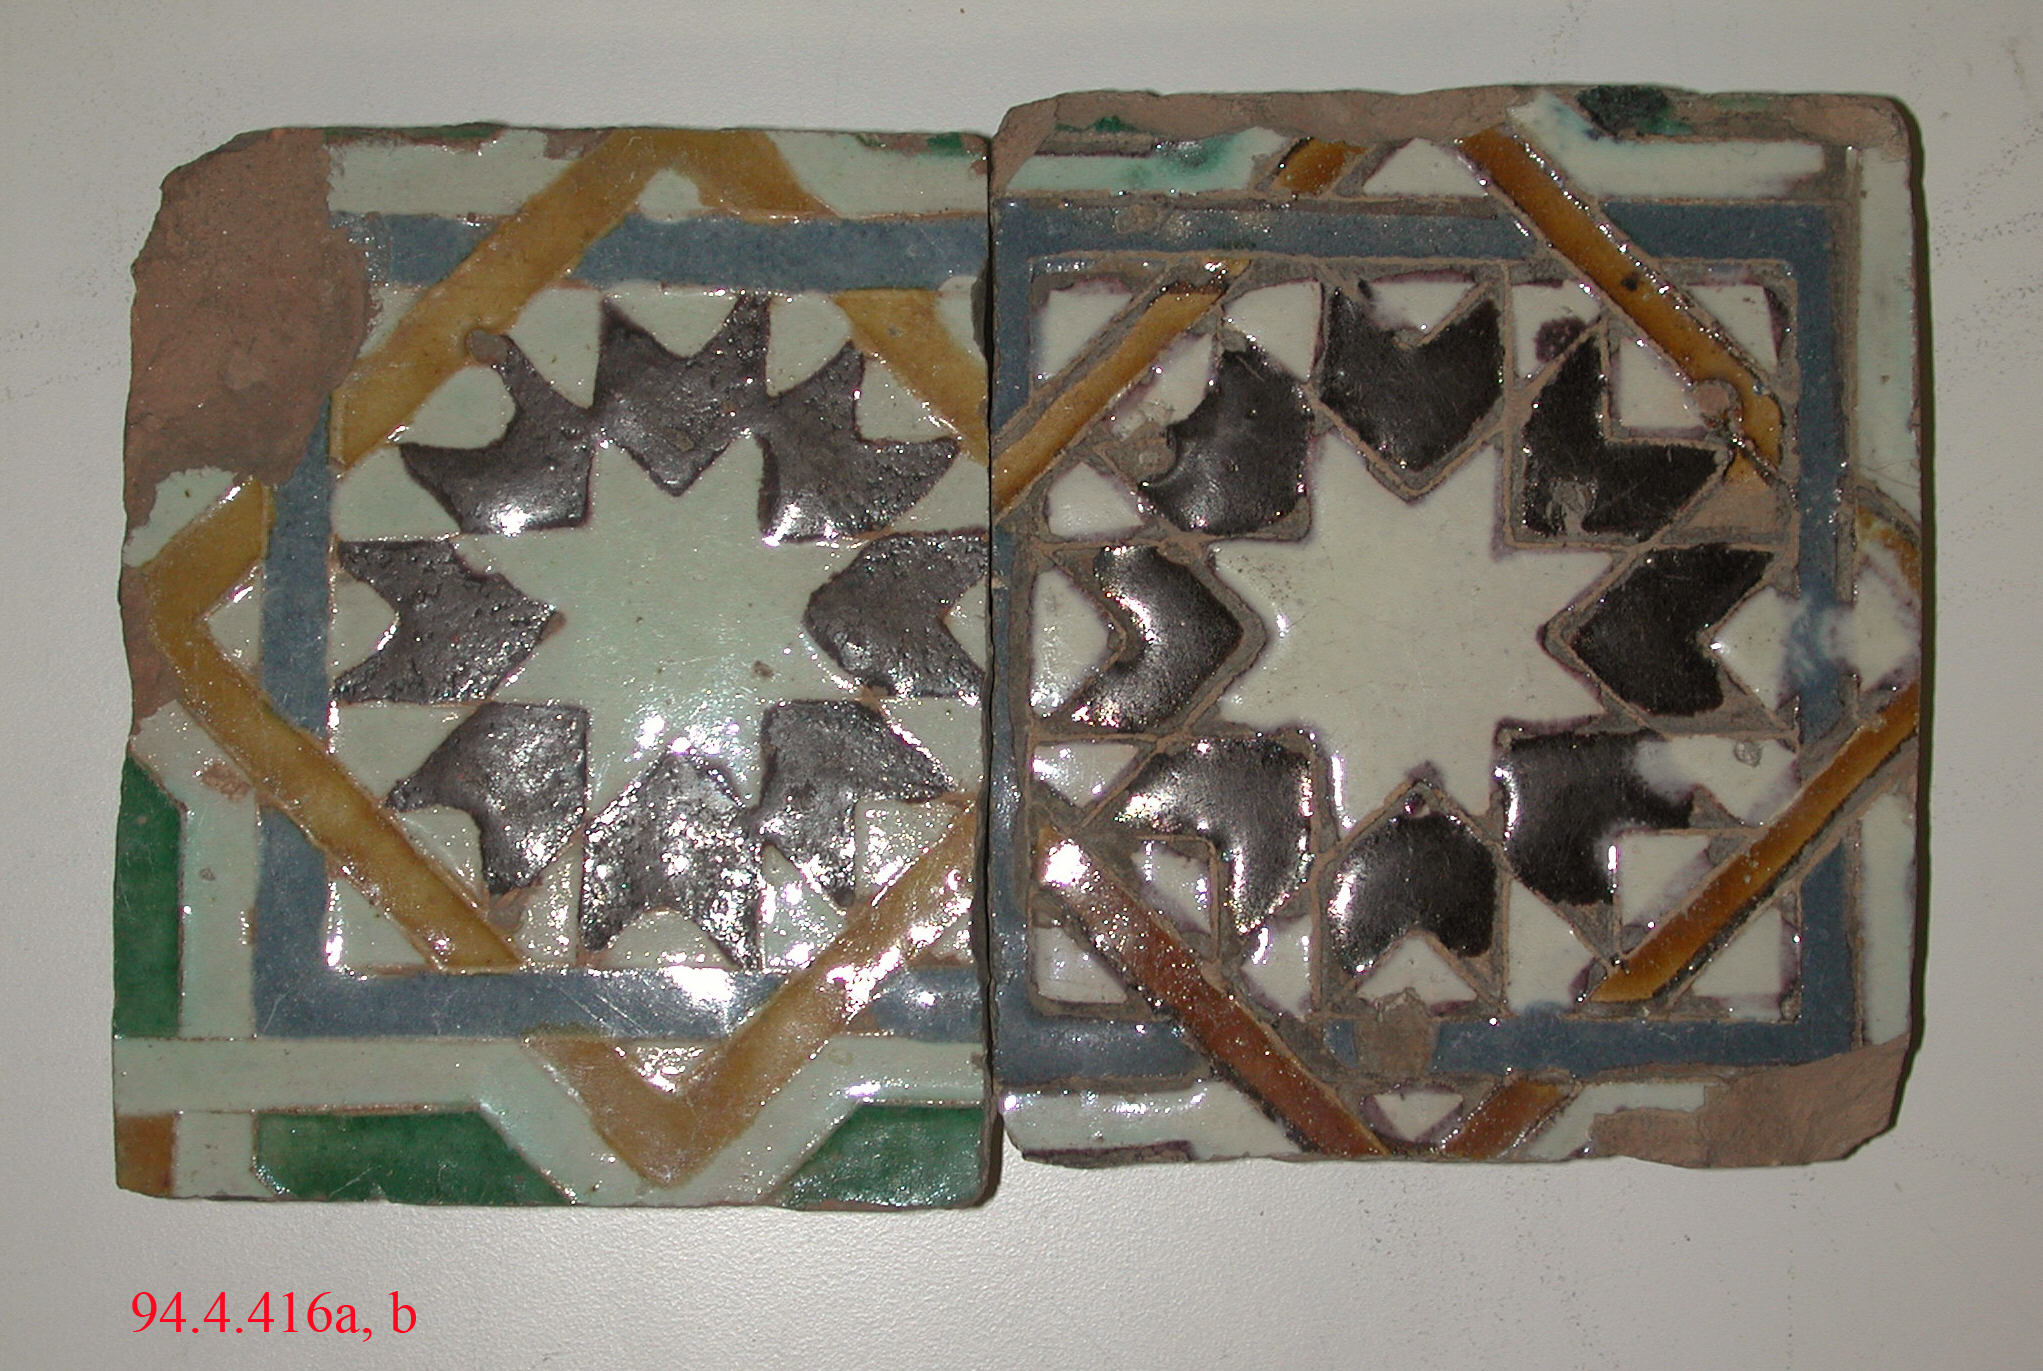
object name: wall tile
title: Wall tiles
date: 1501-1600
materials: earthenware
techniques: glazing